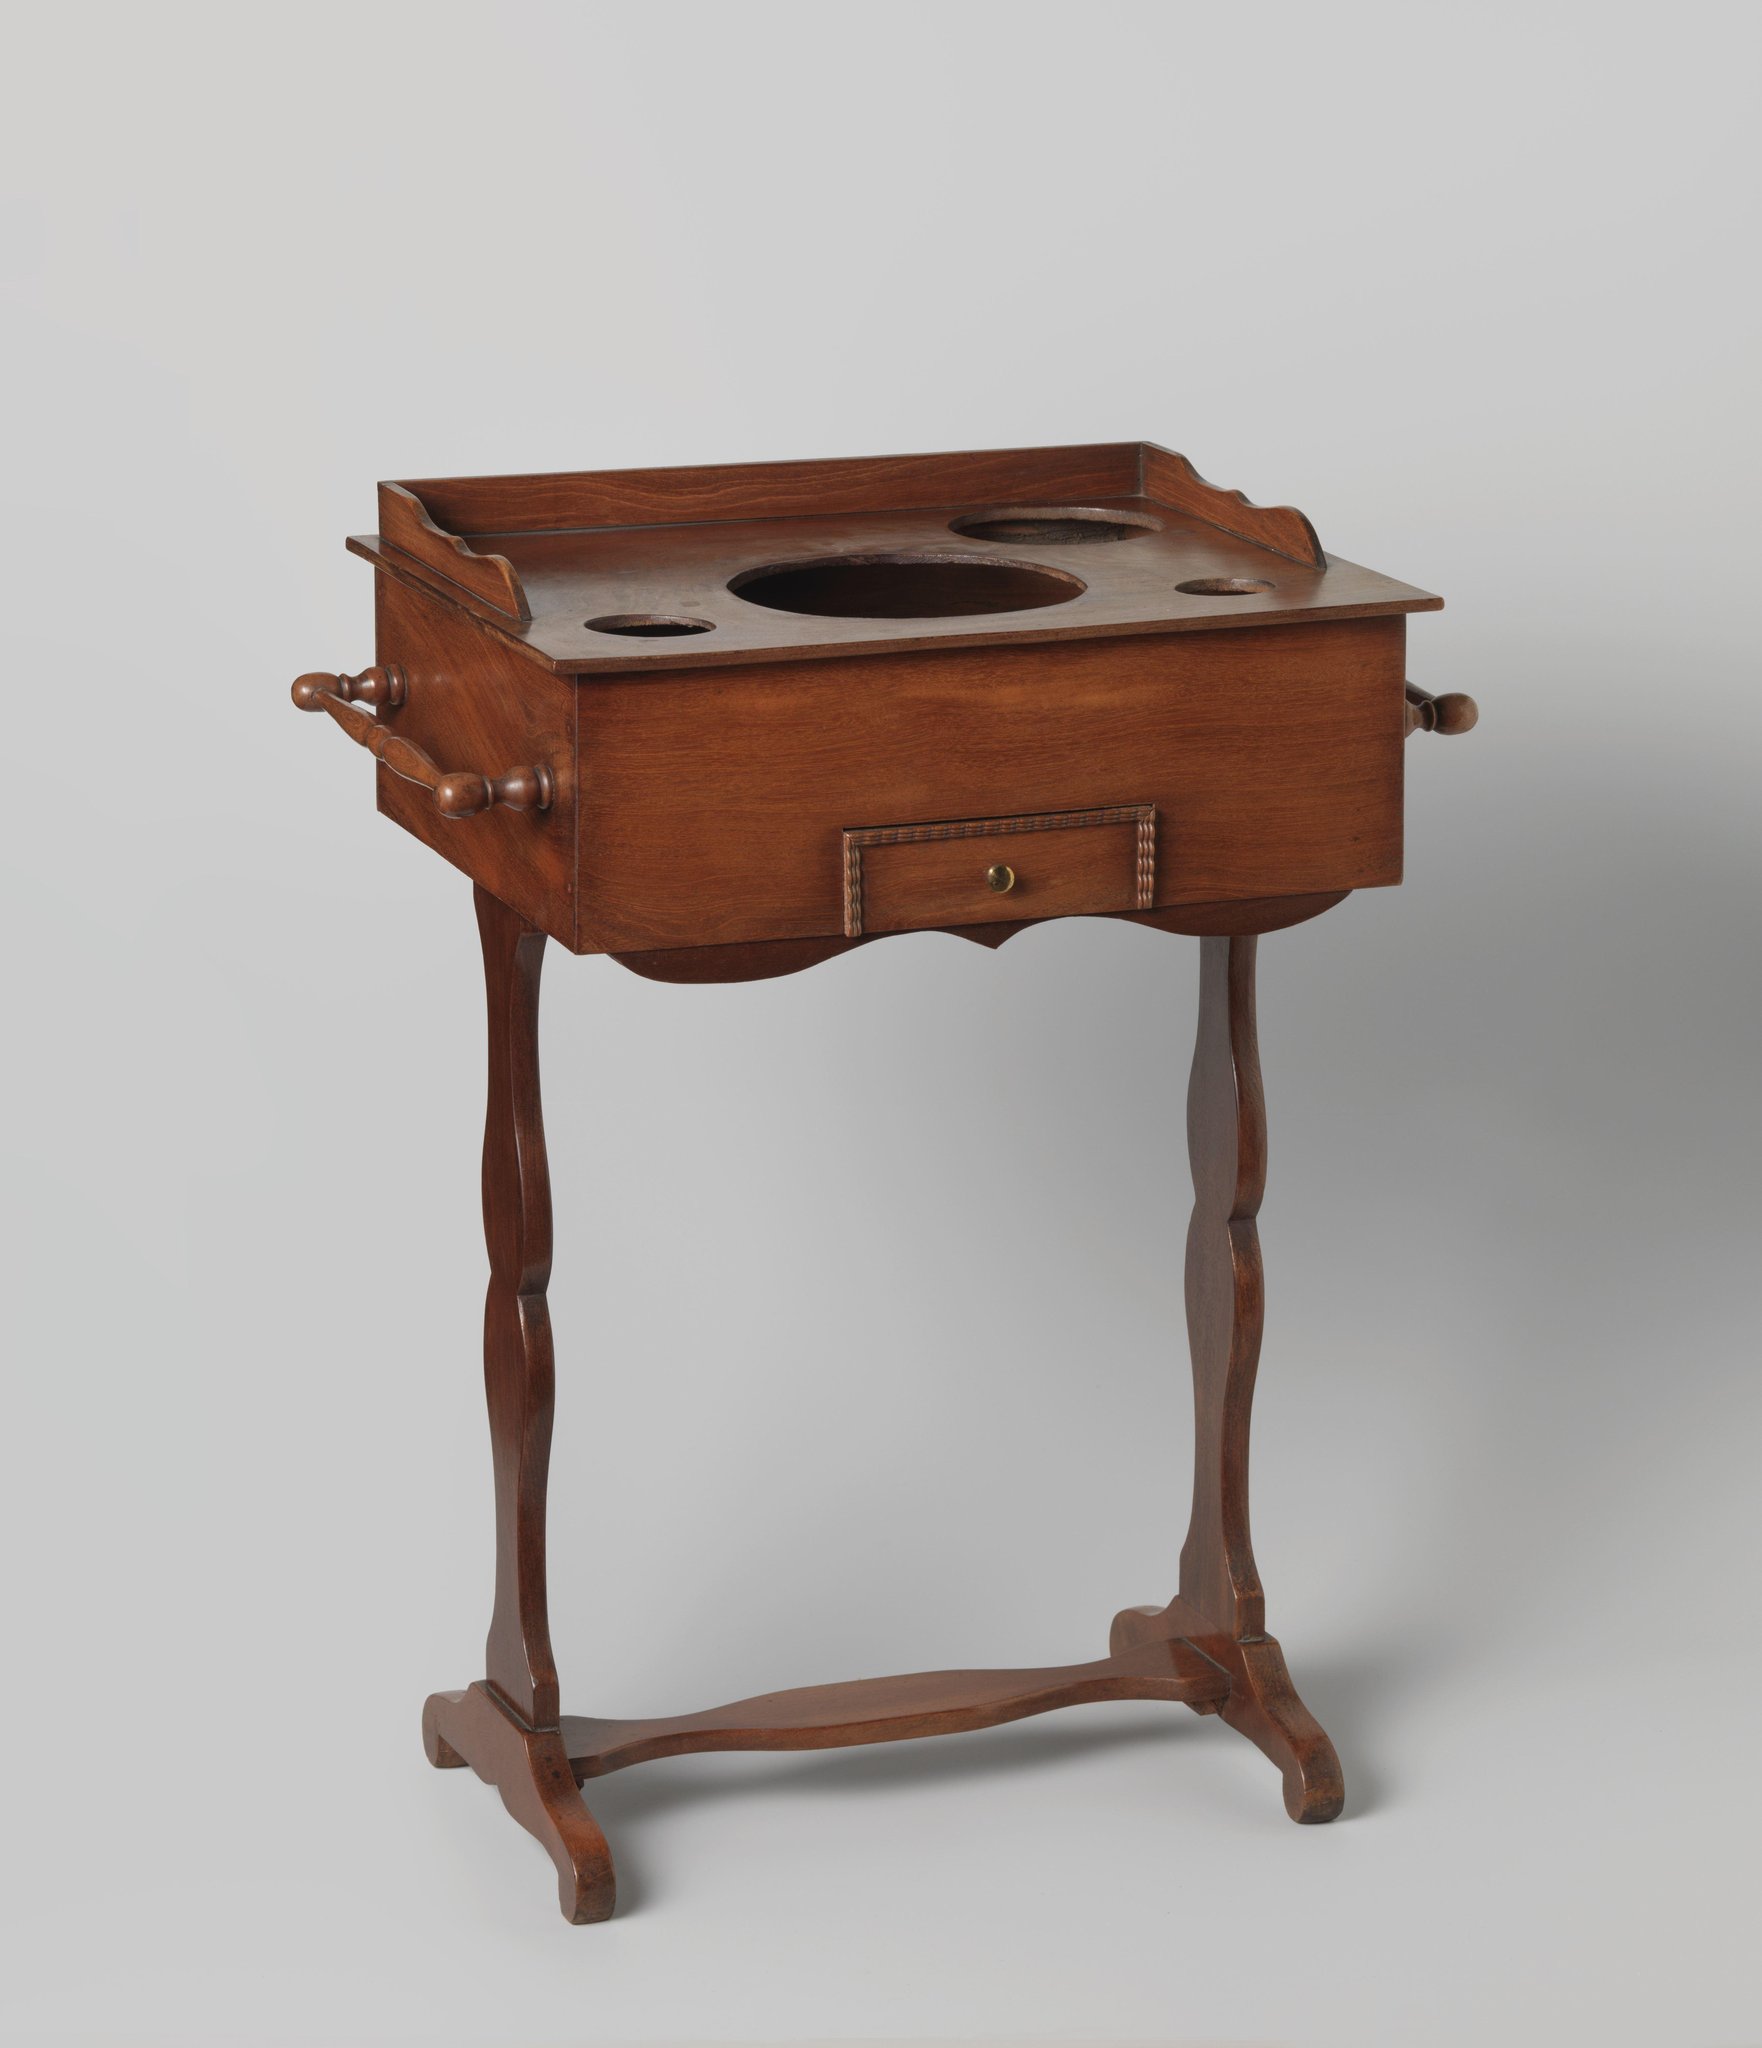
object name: lavatory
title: Poppenwastafel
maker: Anonymous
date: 1775-1800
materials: wood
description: Poppenwastafel, mahoniehout. Op twee poten, van onderen verbonden. In het midden een laatje waarom een golfrandje, knopje ontbreekt. Aan de zijkanten twee handdoekenrekjes.